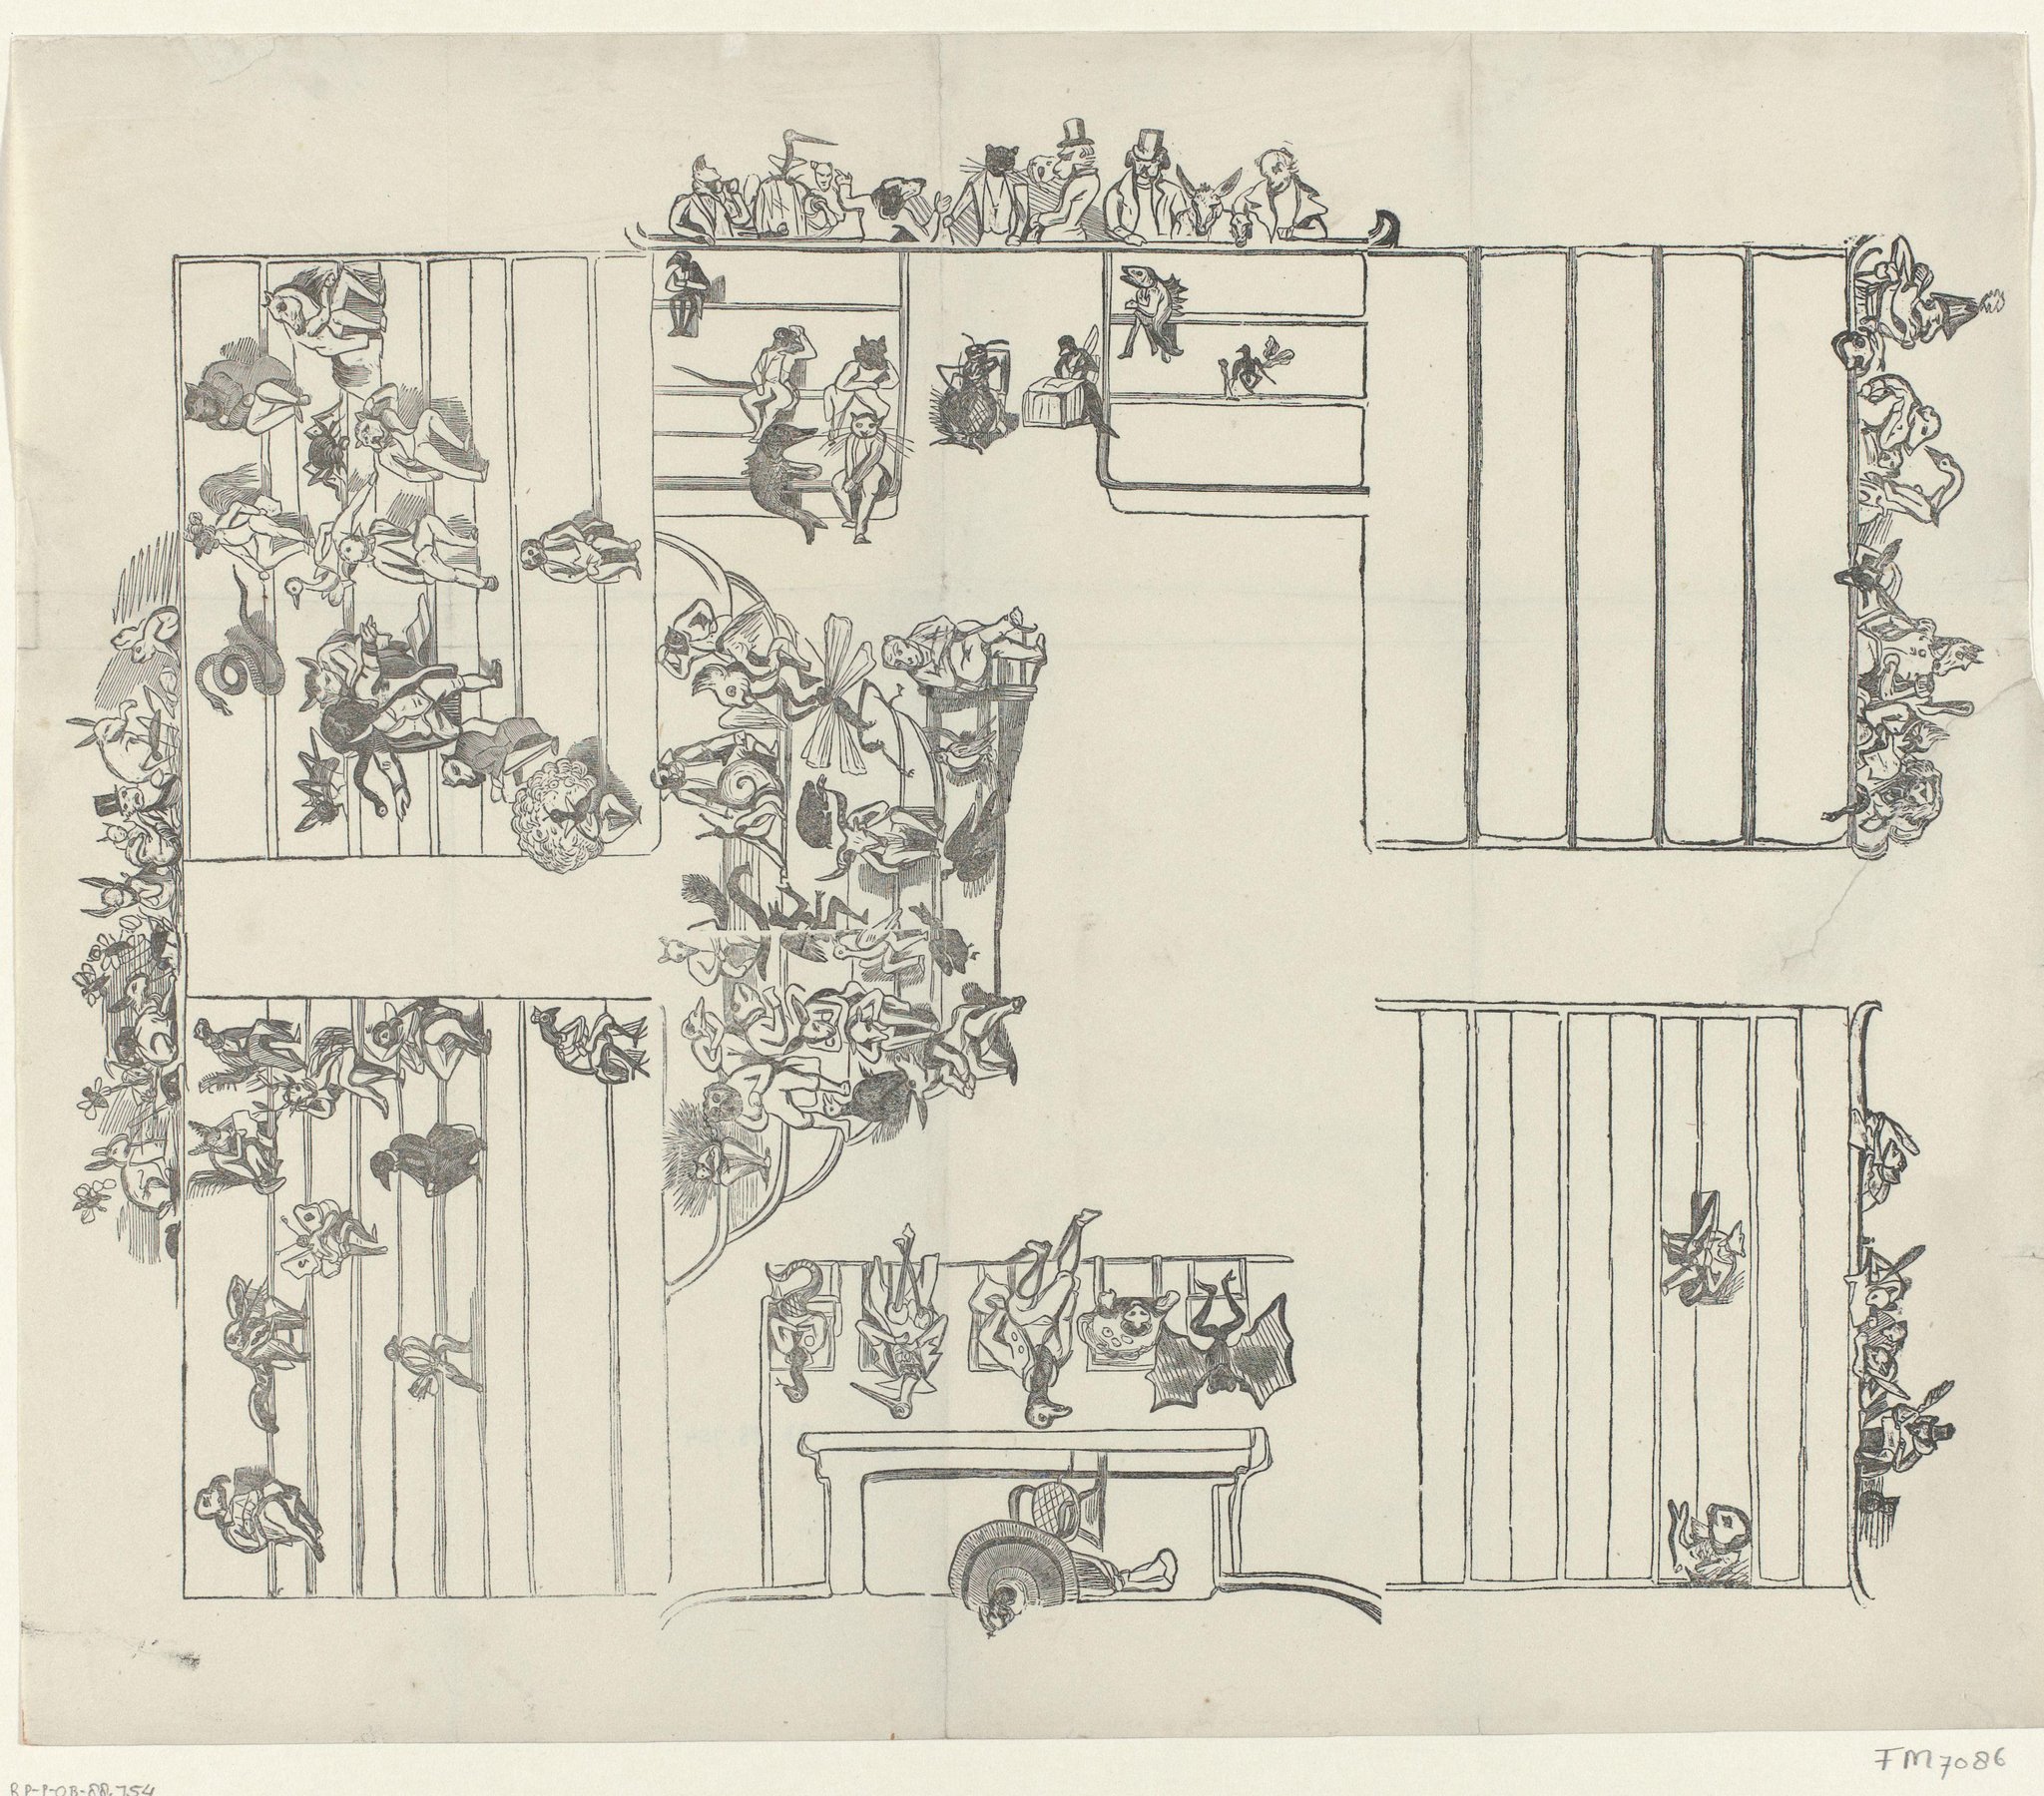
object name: print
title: Politiek beestenspel, 1845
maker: Anonymous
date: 1845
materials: paper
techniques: lithograph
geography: netherlands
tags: animals acting as human beings, lower house, parliament, chamber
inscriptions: collector's mark: Lugt 2228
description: Plattegrond van een vergadering van de Tweede Kamer der Staten-Generaal waarin alle kamerleden als dieren zijn voorgesteld. Zonder namen of nummers. Spotprent op de verwerping door de kamer in mei 1845 van het 'Voorstel der Negenmannen', een voorstel tot grondwetsherziening ingediend op 10 december 1844.